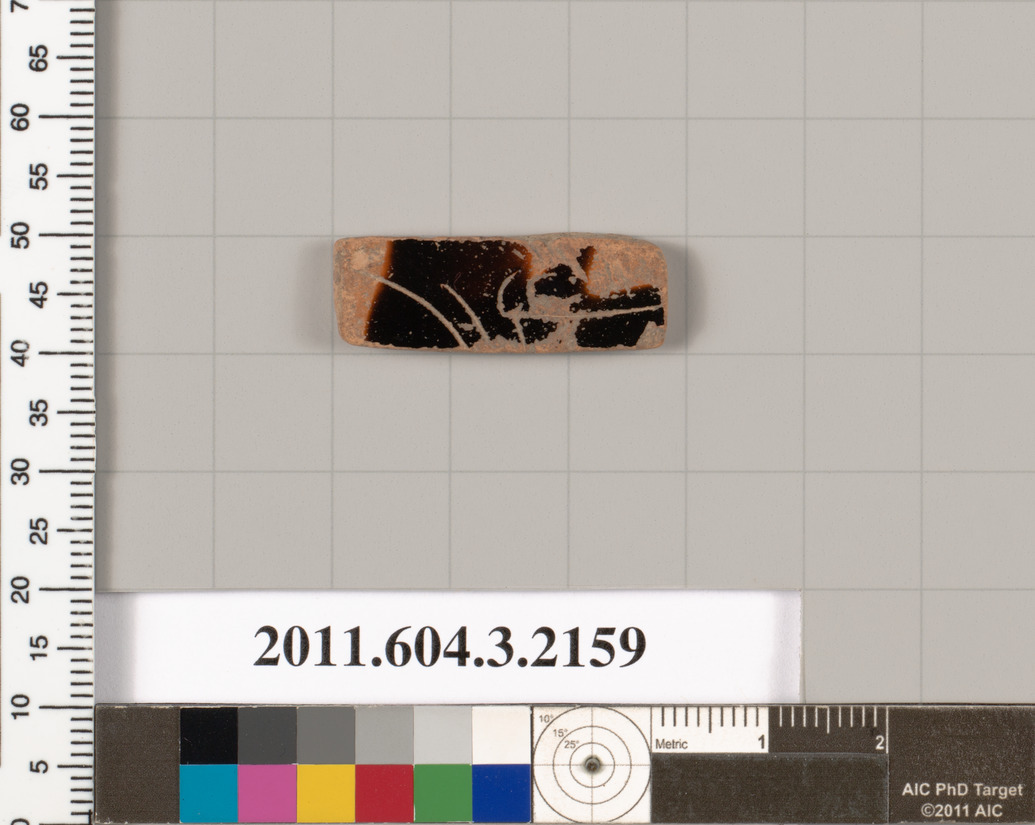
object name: kylix fragment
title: Terracotta fragment of a kylix (drinking cup)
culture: greek, attic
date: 534-468 BCE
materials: terracotta